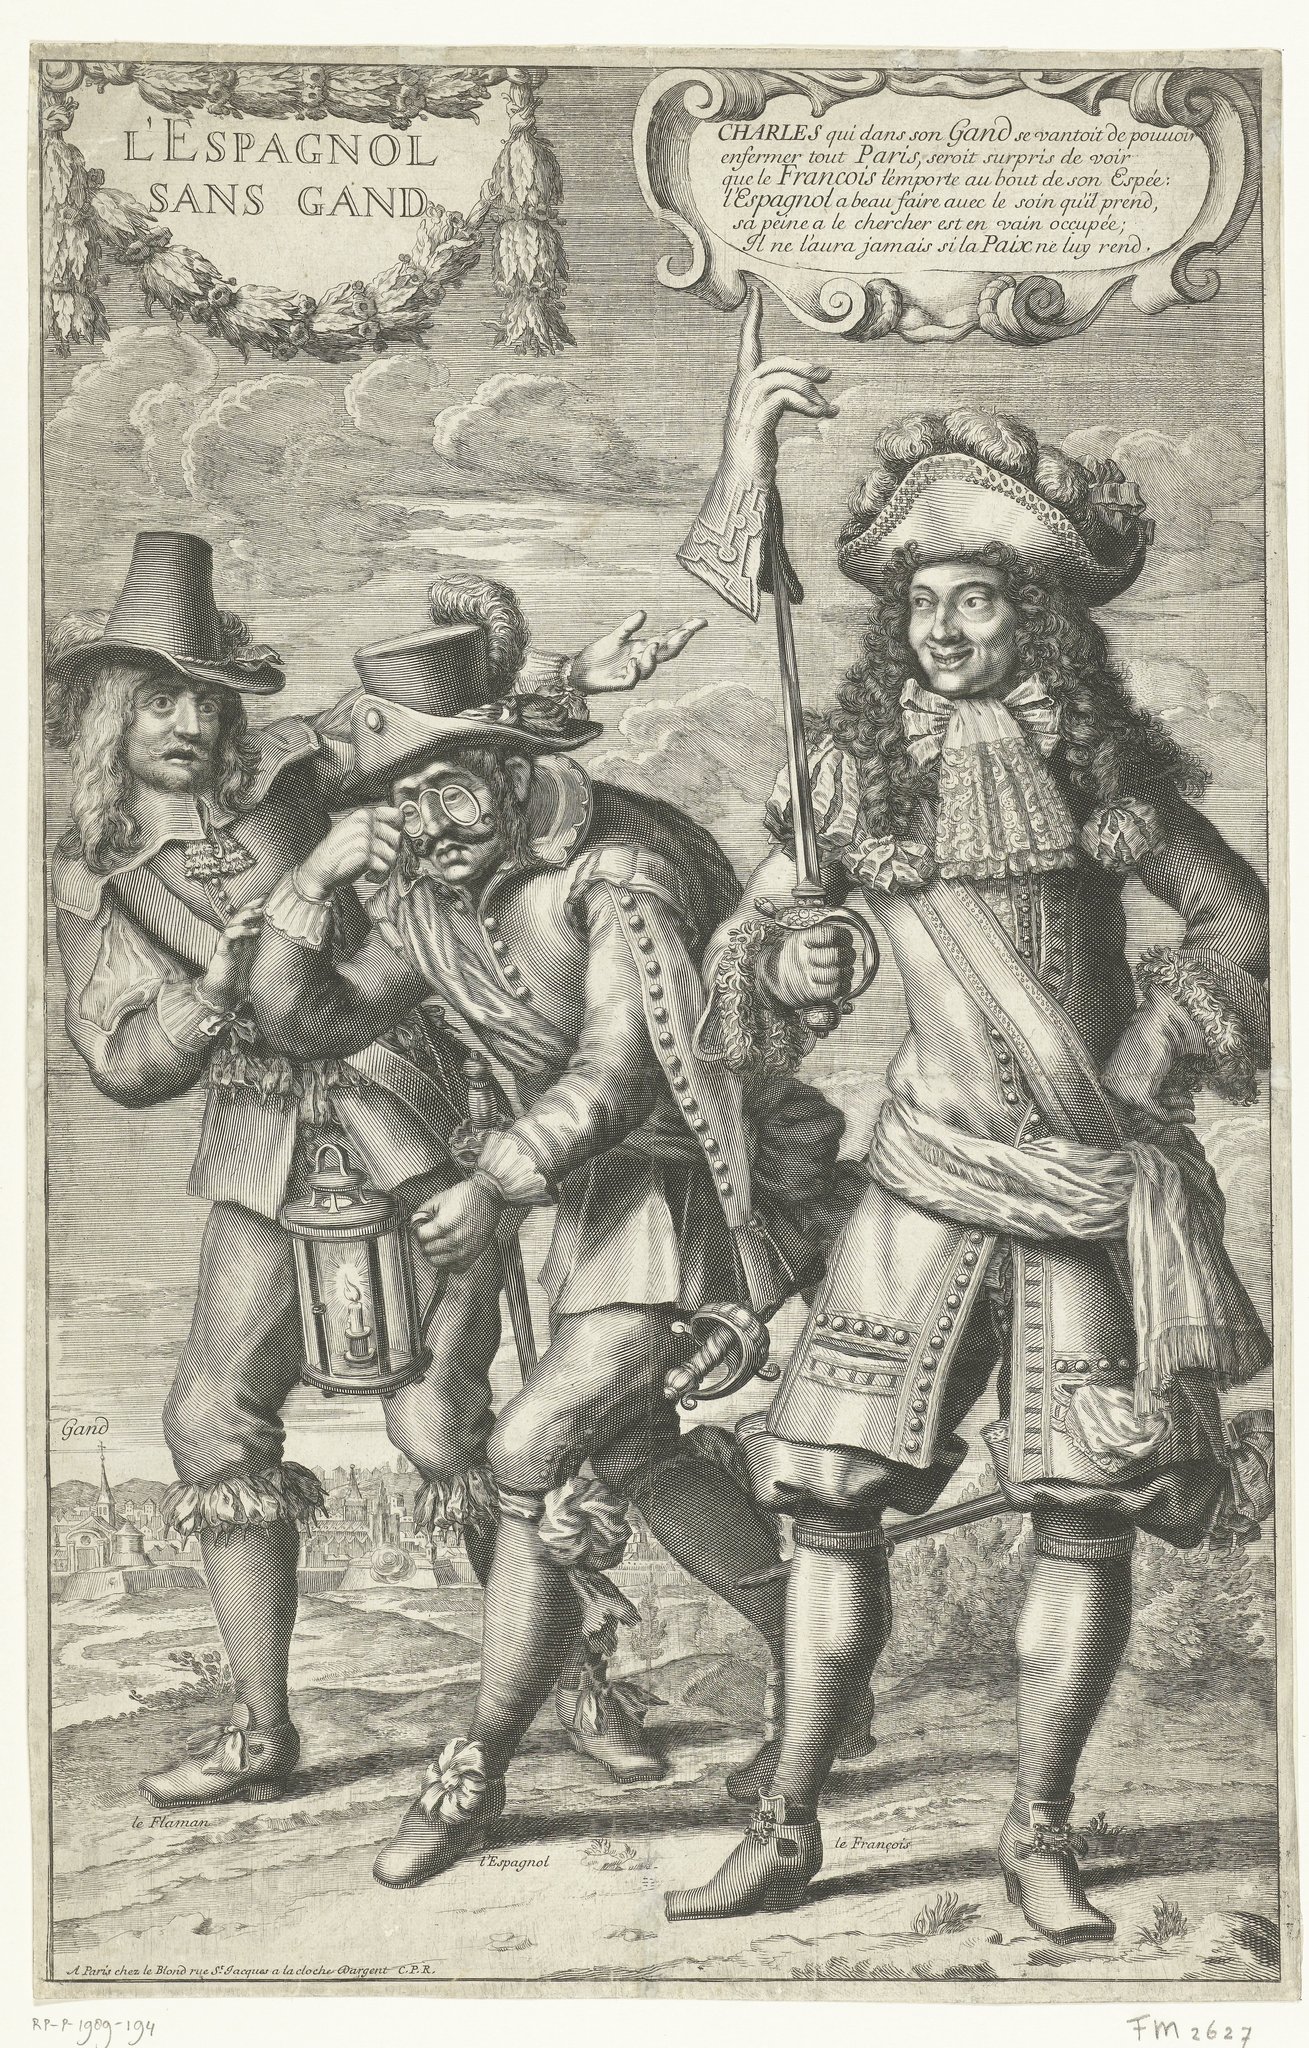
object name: cartoon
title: L'Espagnole sans Gand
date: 1678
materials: paper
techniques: engraving, etching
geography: france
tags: political caricatures and satires, ghent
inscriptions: collector's mark: Lugt 2760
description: Franse spotprent op het verlies van Gent. De stad werd op 9 maart 1678 ingenomen door het Franse leger onder koning Lodewijk XIV. Een Spanjaard zoekt tevergeefs met bril en lantaarn naar zijn verloren handschoen (gand - Gent) die de Fransman op de punt van zijn zwaard heeft. Een Vlaming wijst de Spanjaard naar de Fransman met de handschoen.